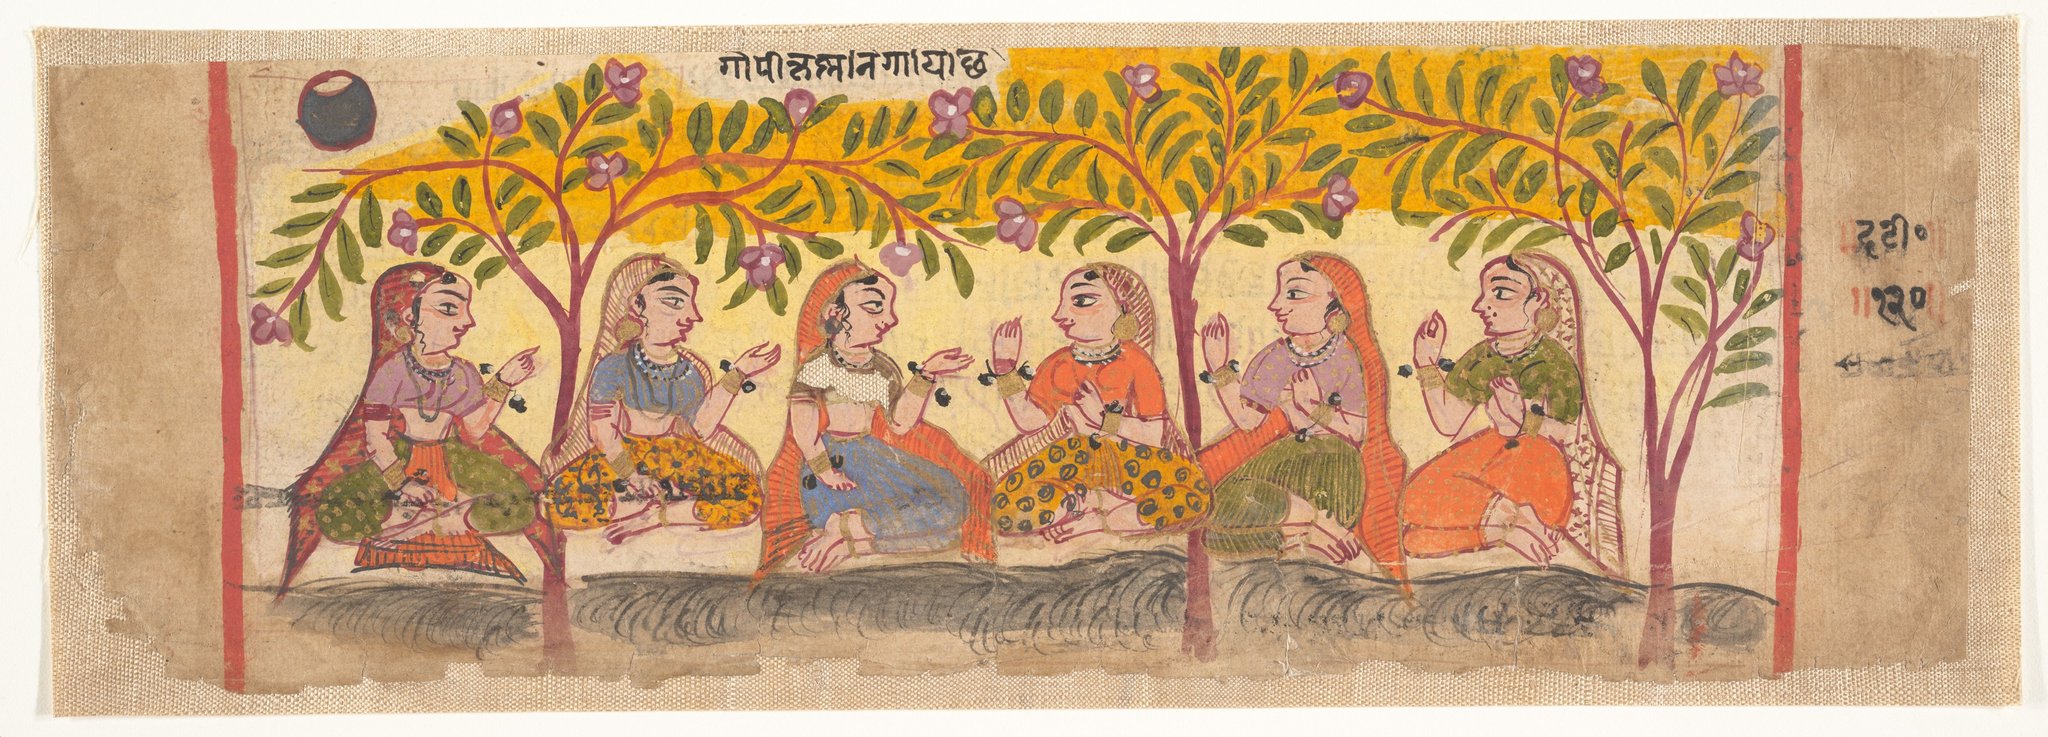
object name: folio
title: Six Gopis Seated Beneath Trees: Page from a Dispersed Bhagavata Purana (Ancient Stories of Lord Vishnu)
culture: indian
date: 1600-1610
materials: ink, paper, watercolor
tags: women